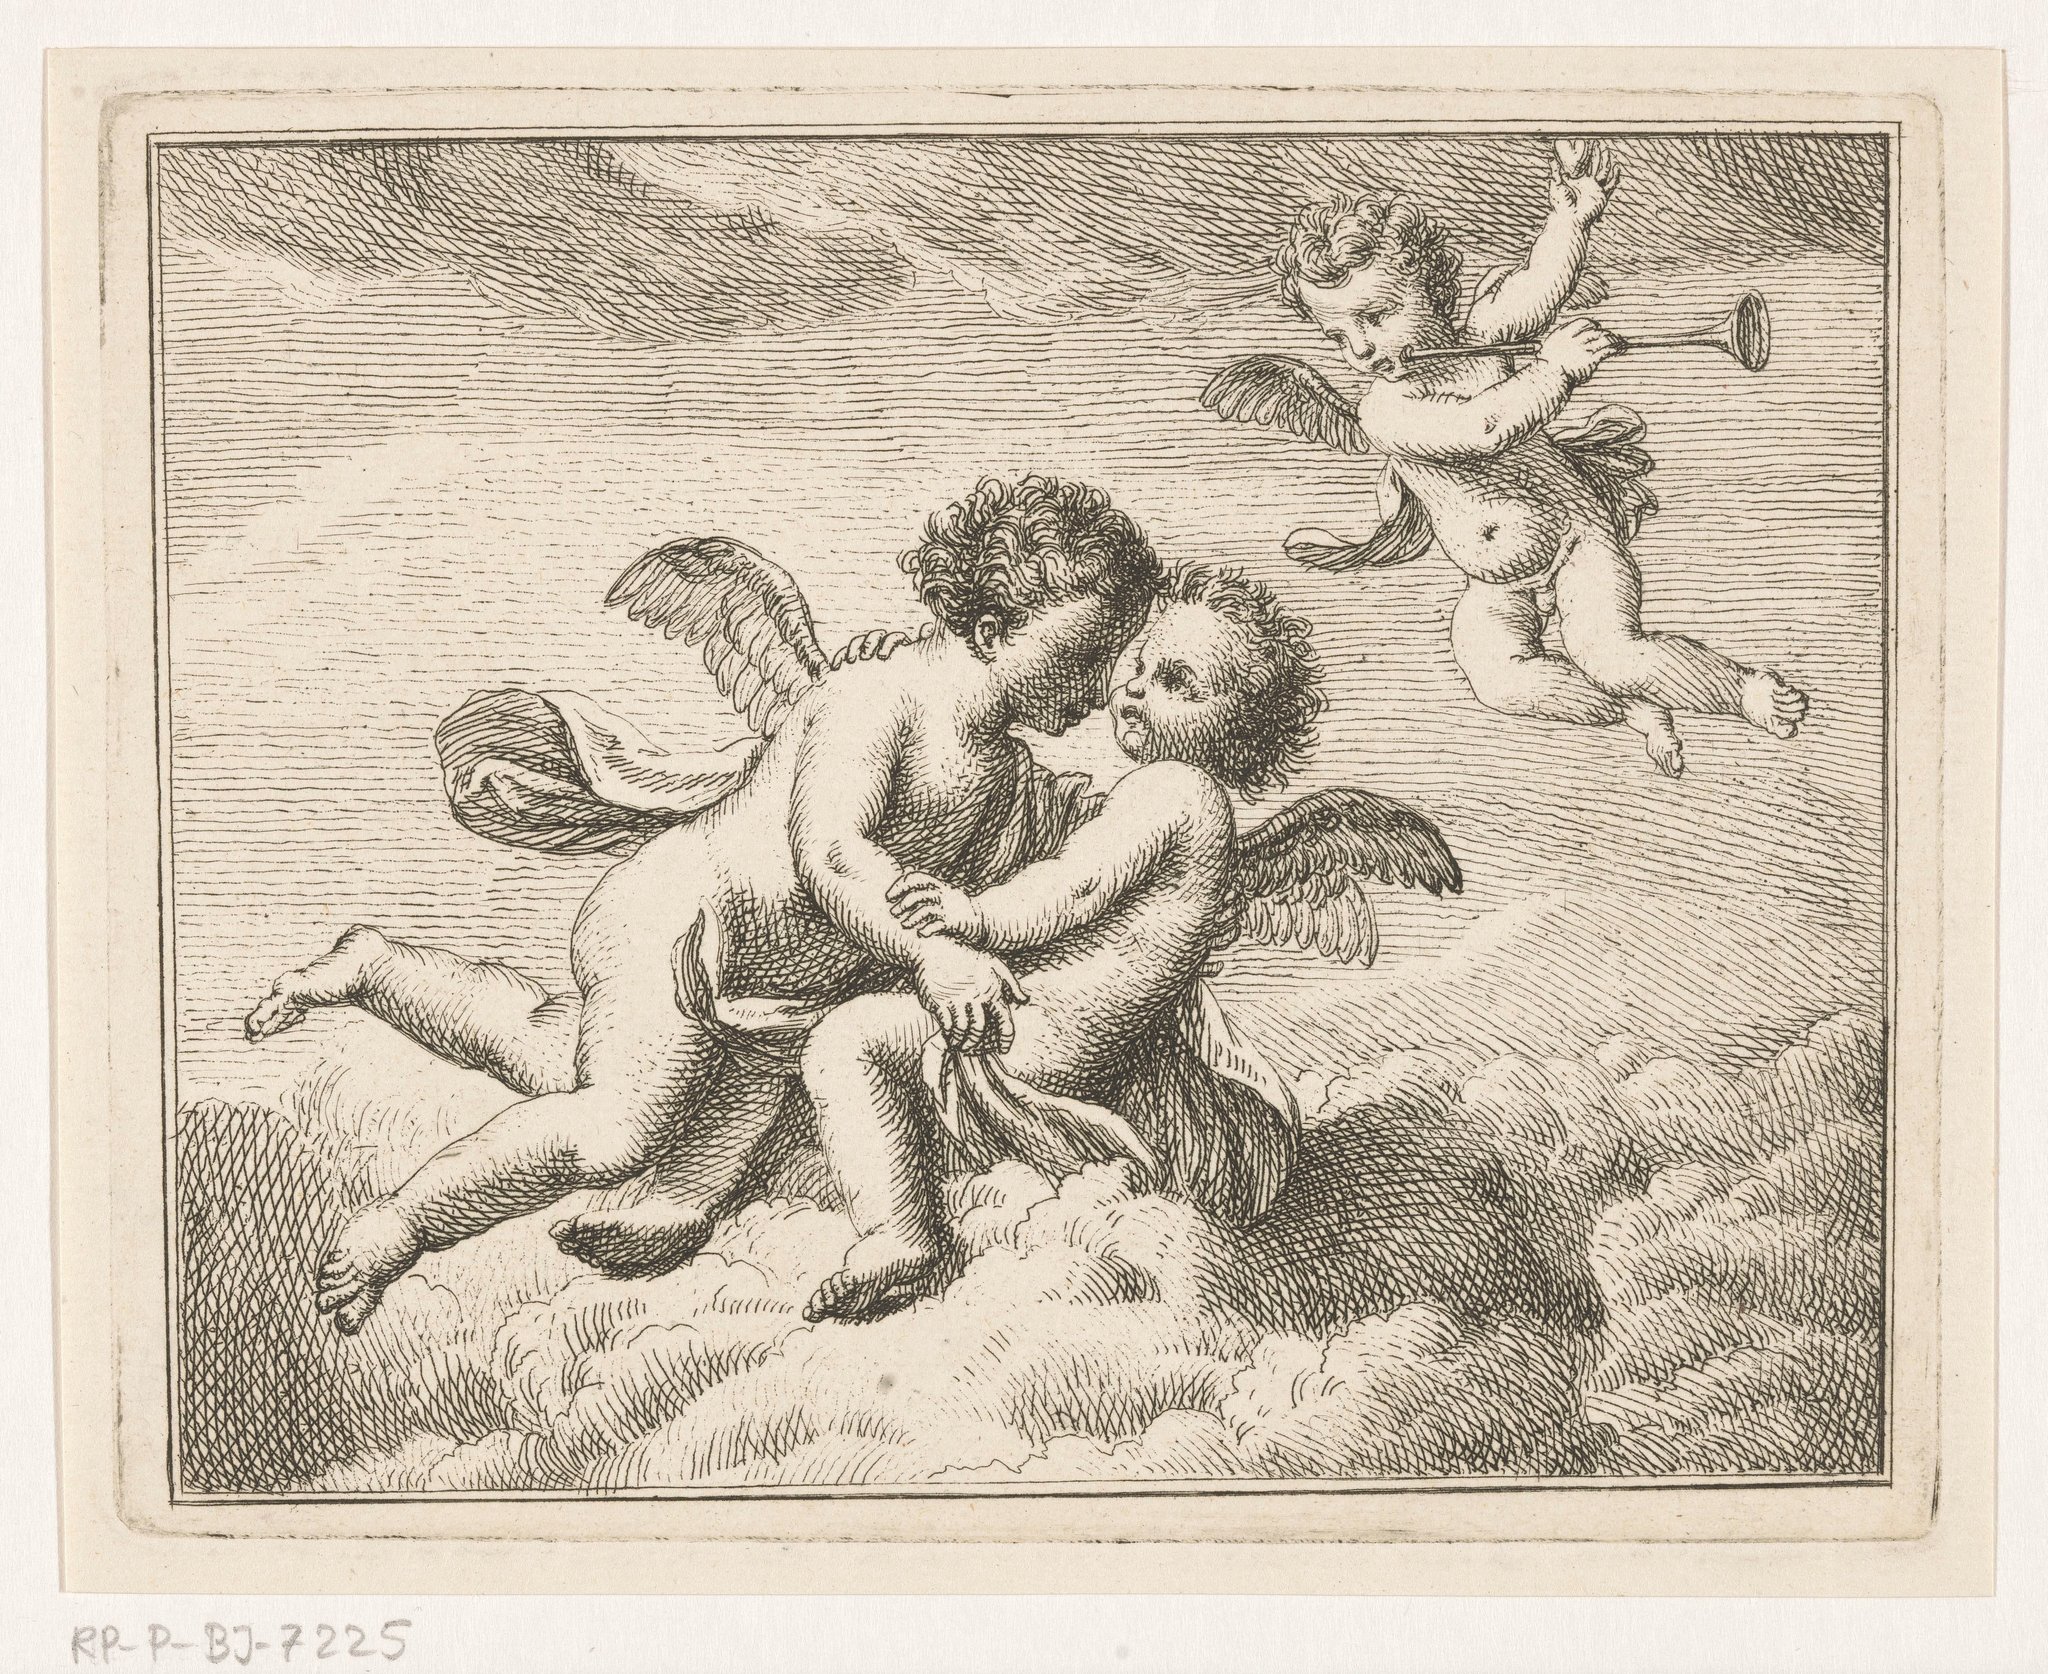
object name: print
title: Drie putti in de wolken, een met een bazuin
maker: louis fabritius dubourg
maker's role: draughtsman, print maker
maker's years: 1693-1775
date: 1713-1775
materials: paper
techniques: etching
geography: amsterdam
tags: cupids: 'amores', 'amoretti', 'putti'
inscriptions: collector's mark: Lugt 240